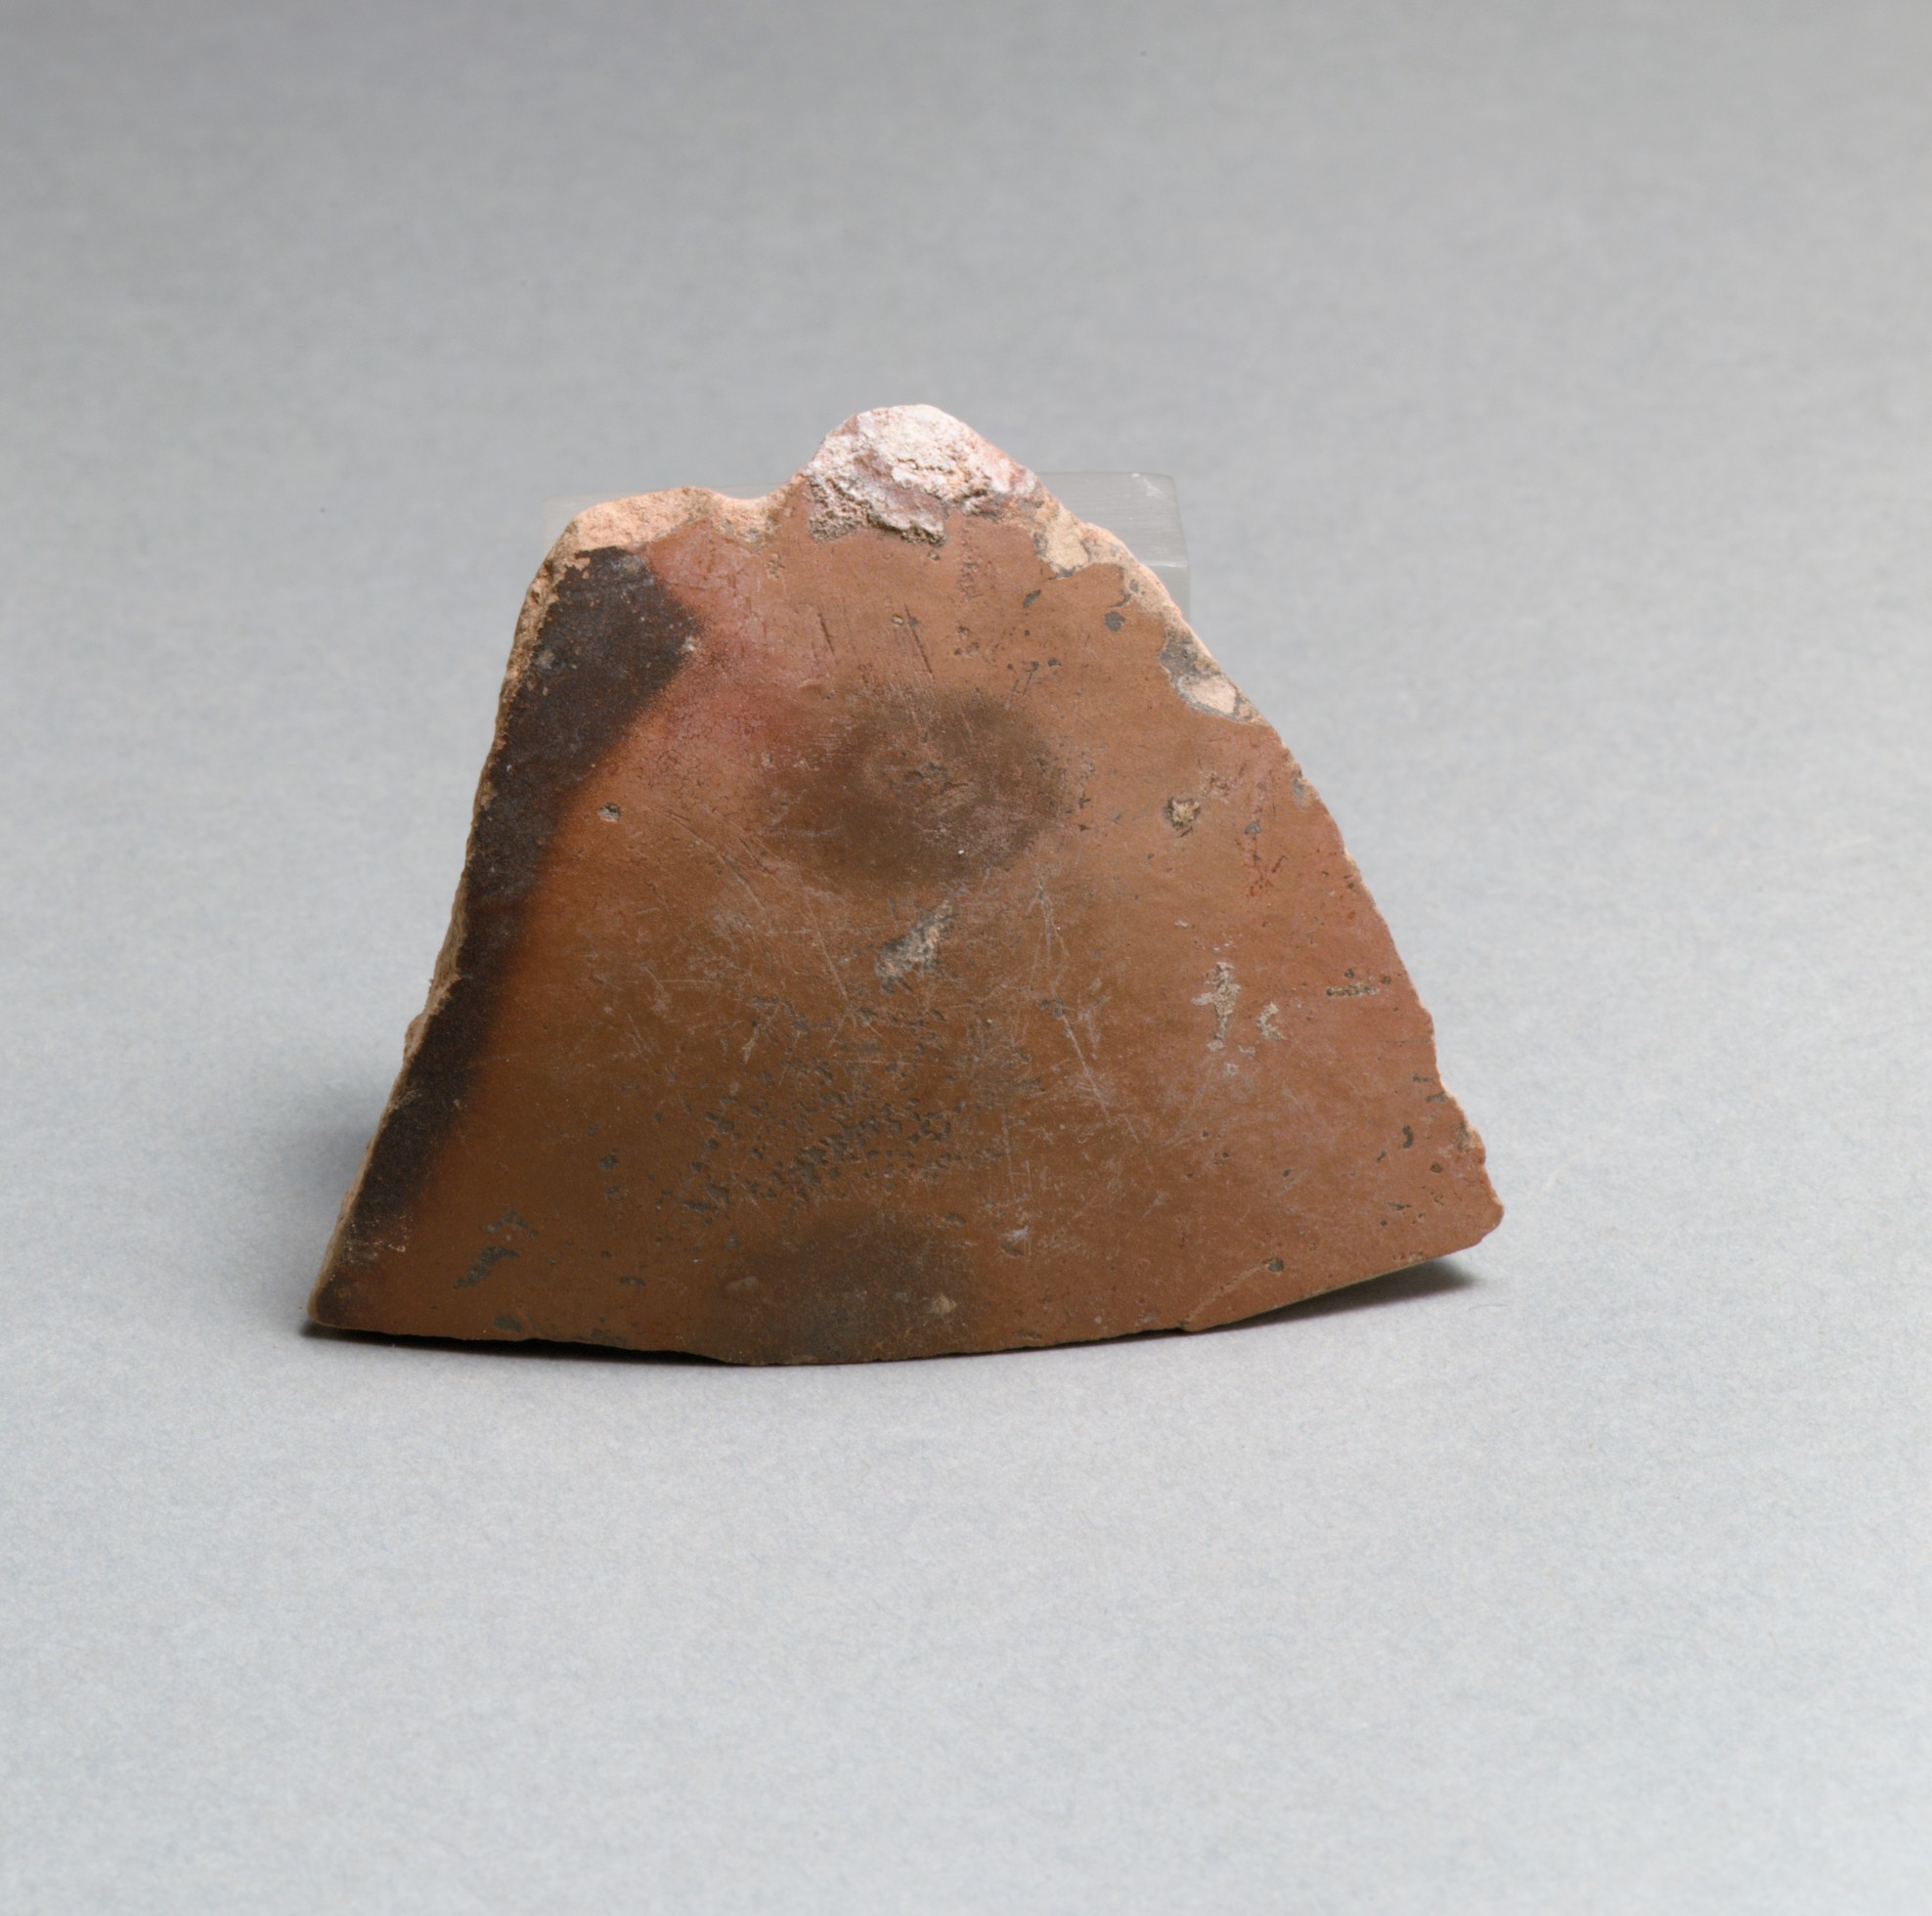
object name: vase fragment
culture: minoan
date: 2600-2000 BCE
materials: terracotta